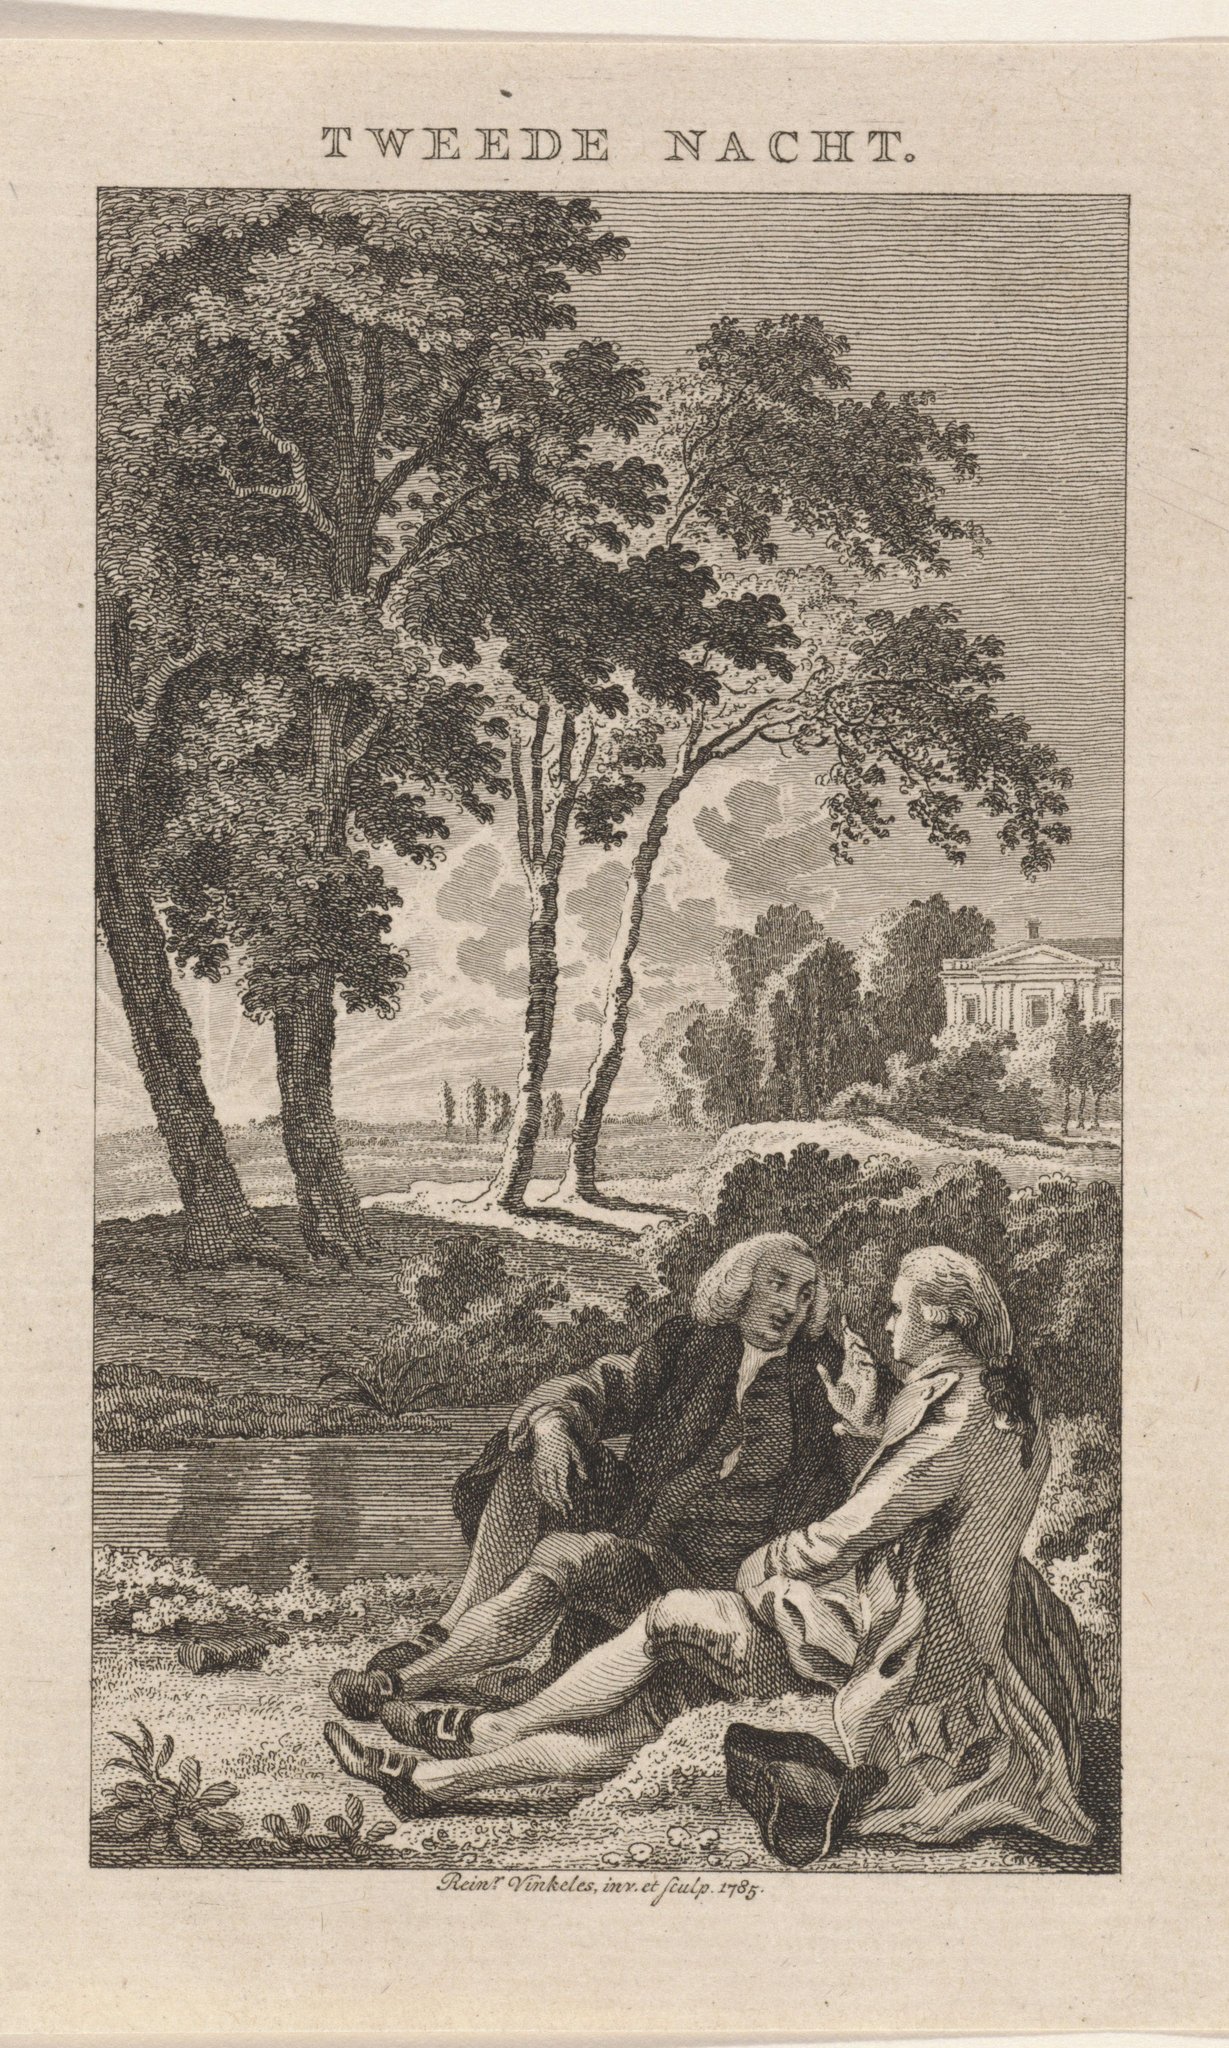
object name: print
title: Twee mannen voeren een gesprek aan de waterkant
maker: reinier vinkeles (i)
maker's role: draughtsman, print maker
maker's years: 1741-1816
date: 1785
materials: paper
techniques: engraving, etching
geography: amsterdam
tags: river bank, conversation, dialogue; conversation piece, night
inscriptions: collector's mark: Lugt 2228